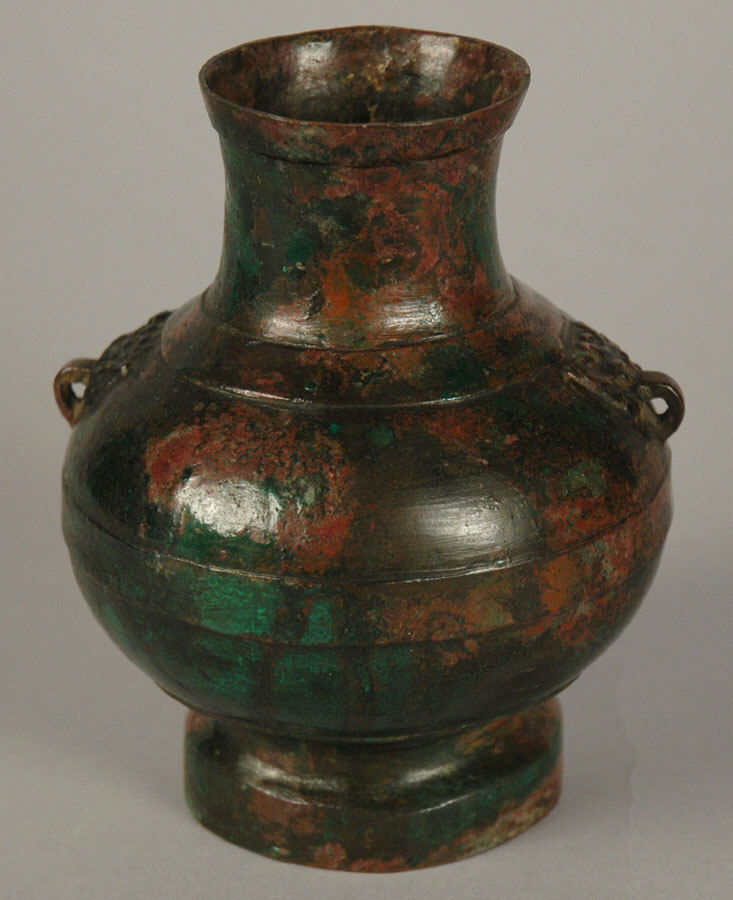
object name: wine container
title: Wine container (Hu) in the style of the Han dynasty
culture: chinese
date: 1701-1800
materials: bronze